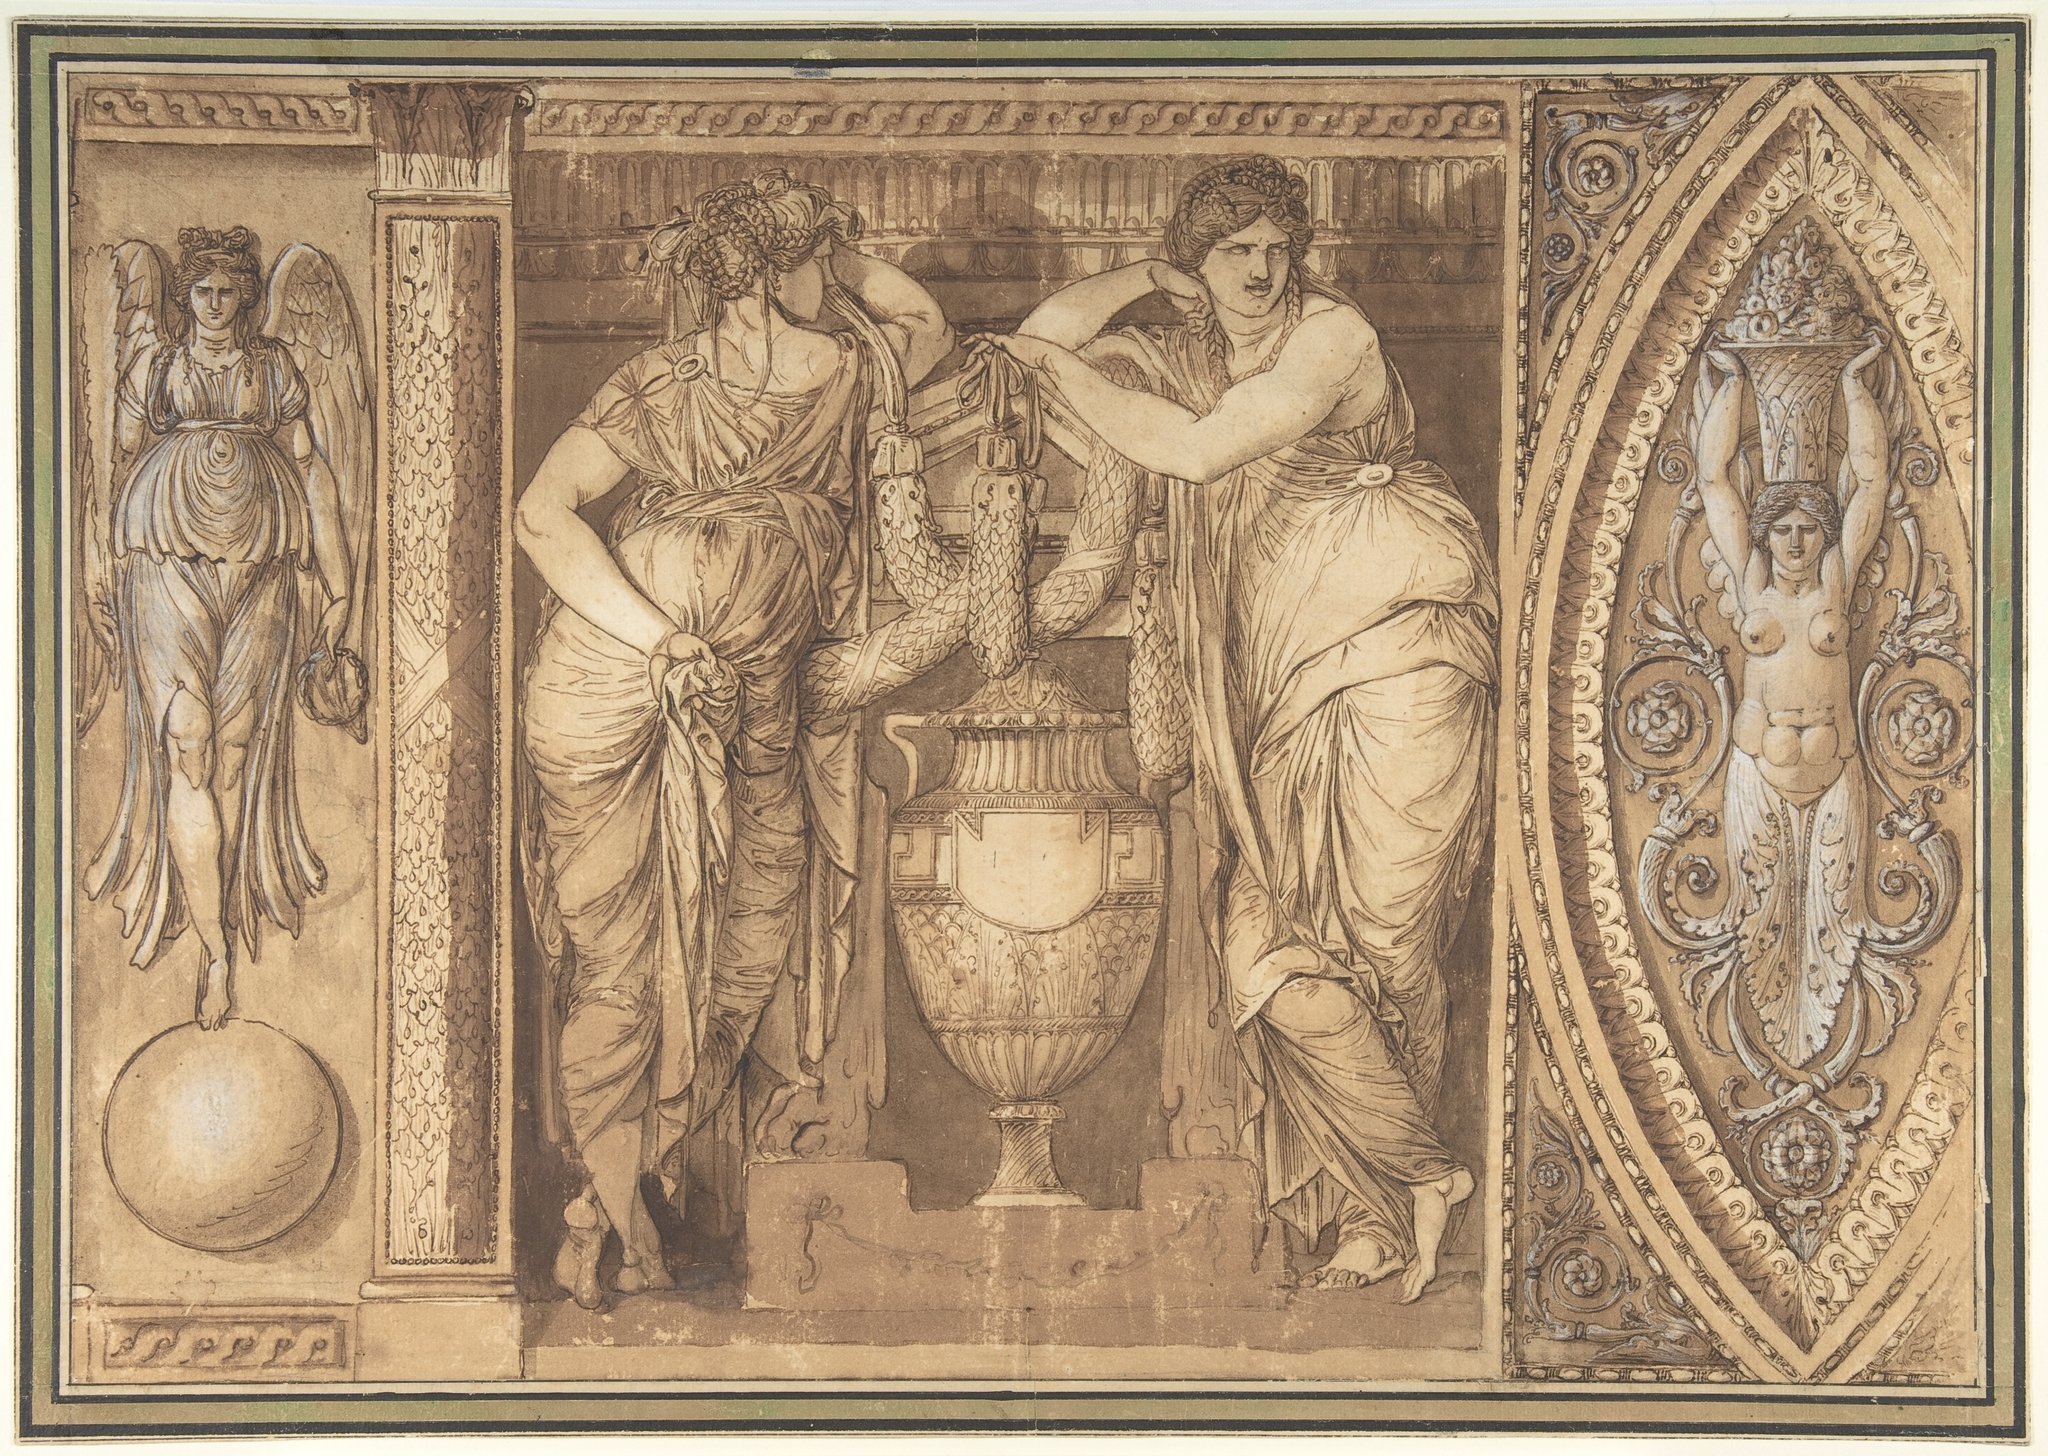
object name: drawing ornament architecture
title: Design for a Frieze with Two Women Flanking an Urn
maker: giuseppe cades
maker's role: artist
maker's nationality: italian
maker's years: 1750-1799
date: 1775-1785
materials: chalk, ink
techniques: brush, highlighting, pen, wash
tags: women,female nudes,urns